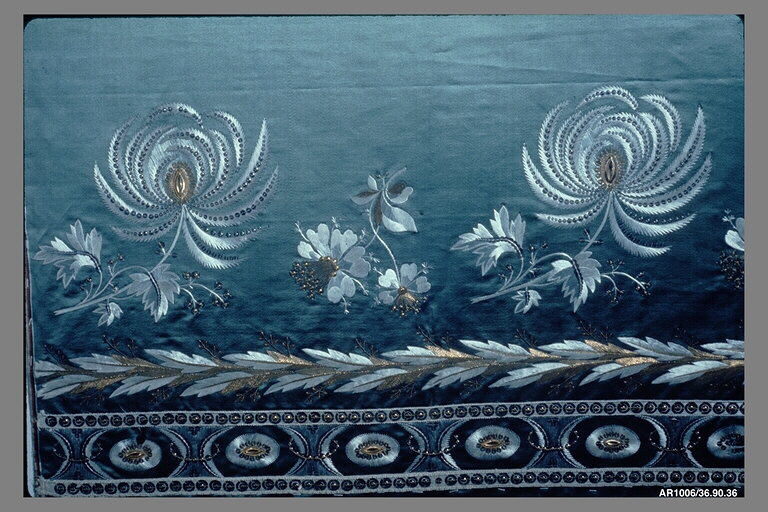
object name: border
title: Dress border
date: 1801-1833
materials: metal thread, silk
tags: flowers